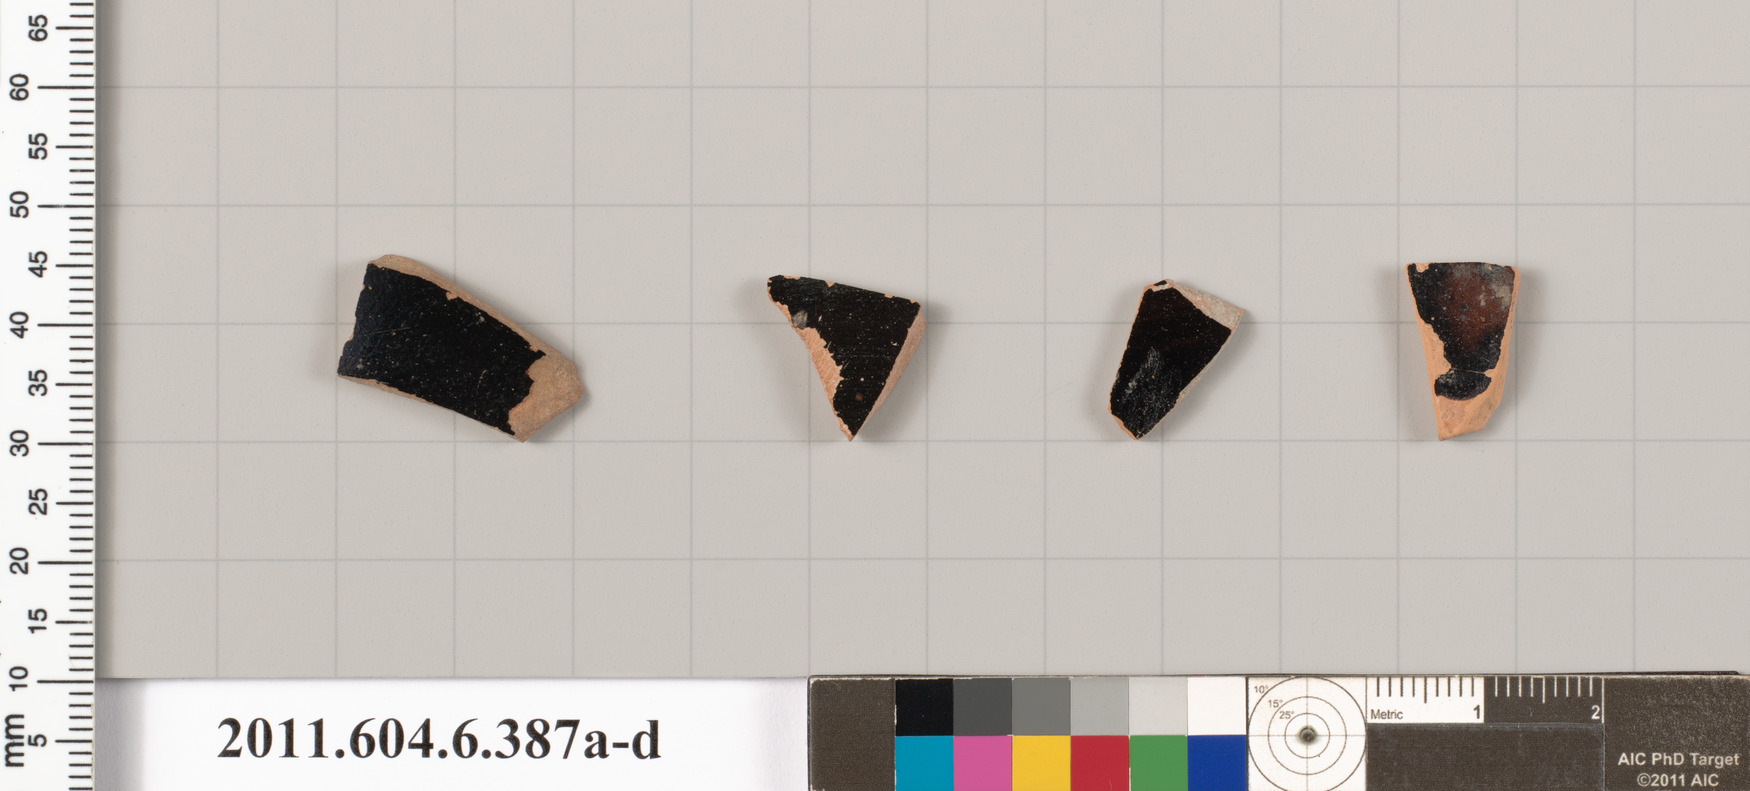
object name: undetermined closed shape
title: Terracotta fragments of closed shapes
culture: greek, attic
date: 600-401 BCE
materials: terracotta